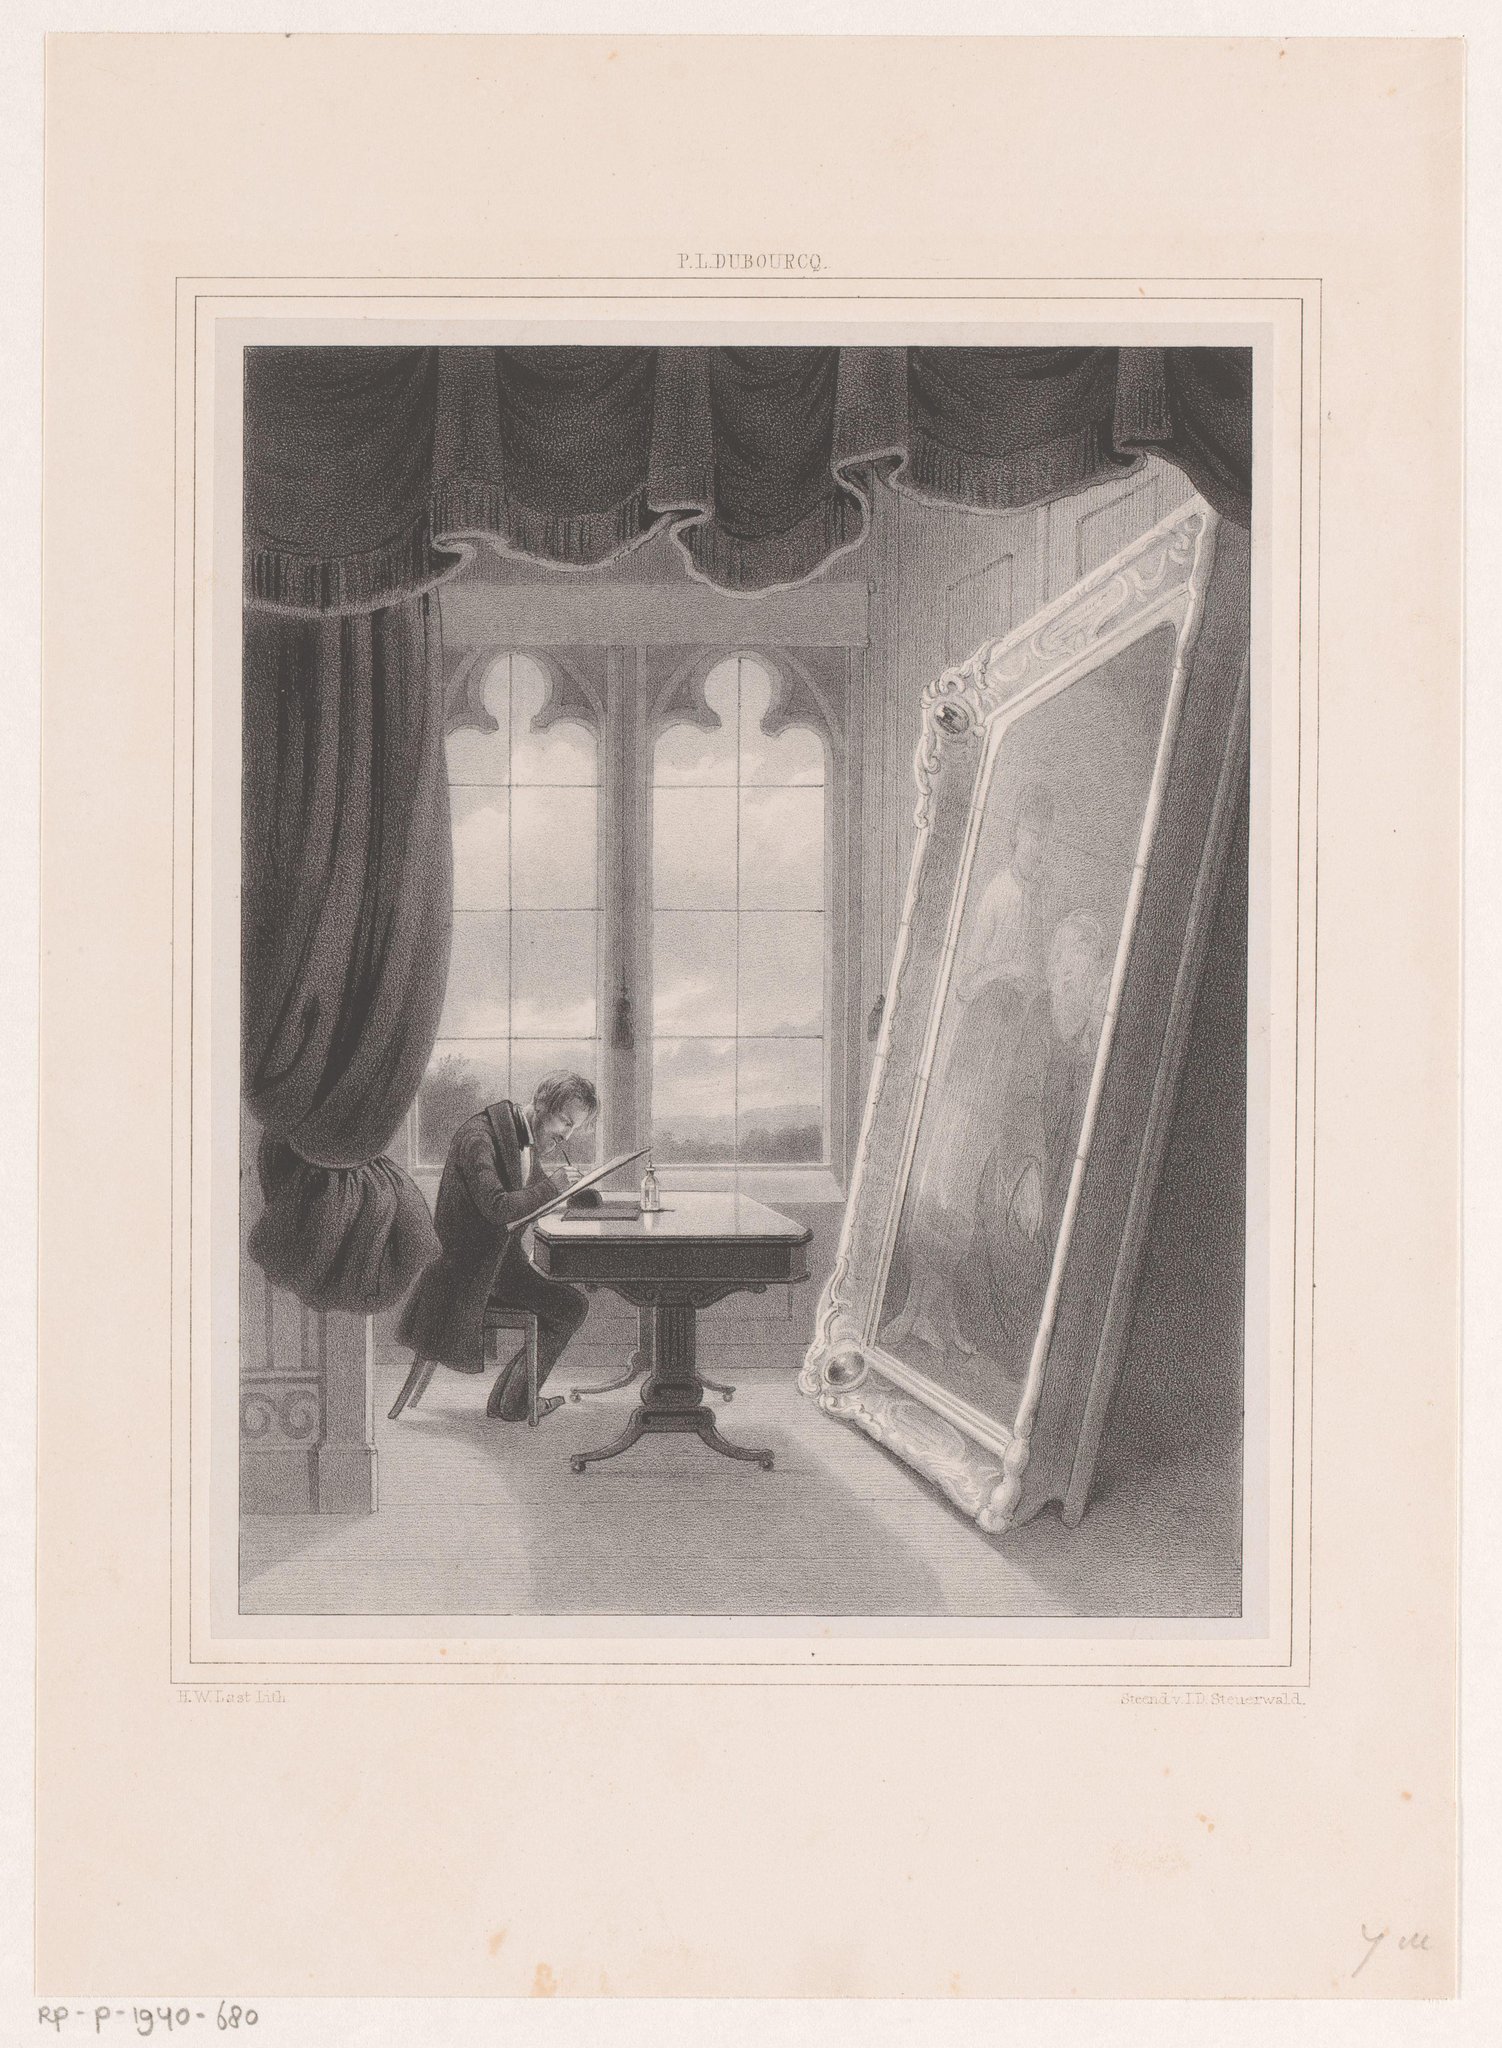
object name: print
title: Henricus Wilhelmus Couwenberg kopieert een schilderij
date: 1846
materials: paper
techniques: lithograph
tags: the hague, amsterdam, print maker, draughtsman, henricus wilhelmus couwenberg, drawing, sketch, picture within picture, artist (in general) making preliminary designs, sketching, picture, painting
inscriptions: collector's mark: Lugt 2760, collector's mark: Lugt 2228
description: De graveur Henricus Wilhelmus Couwenberg bezig op het kasteel te Windsor met het kopiëren van het schilderij 'Mignon en de oude harpenaar' van Ary Scheffer uit 1844.